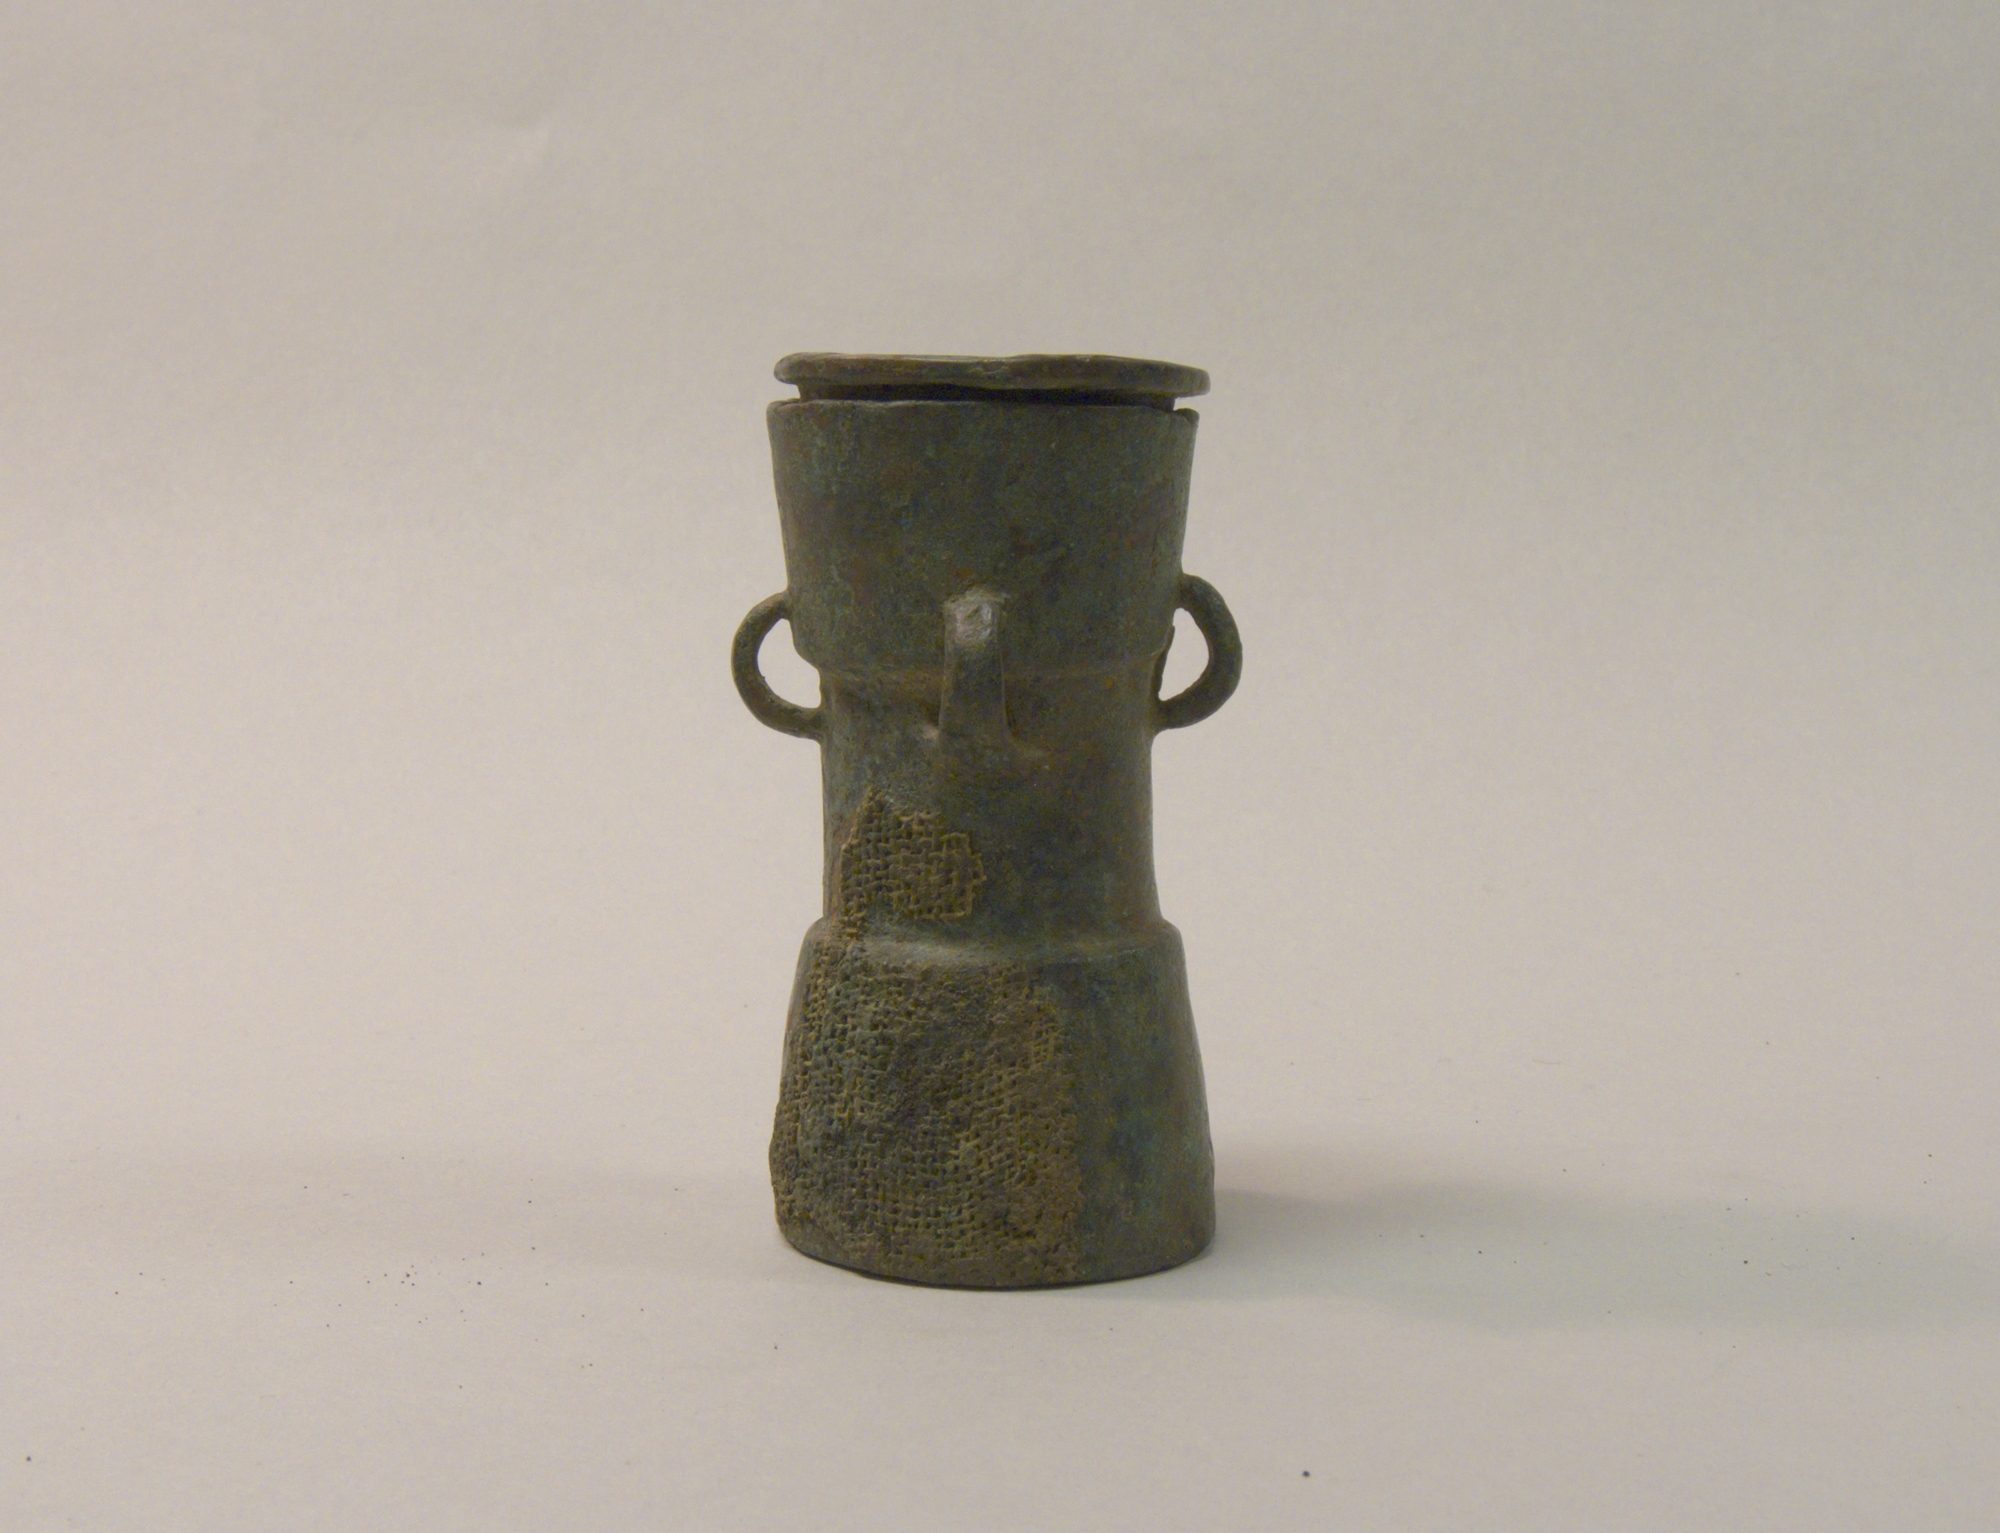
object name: lime container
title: Lime Container in the Form of a "Mloko" Drum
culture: indonesian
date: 500 BCE-300 CE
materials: bronze